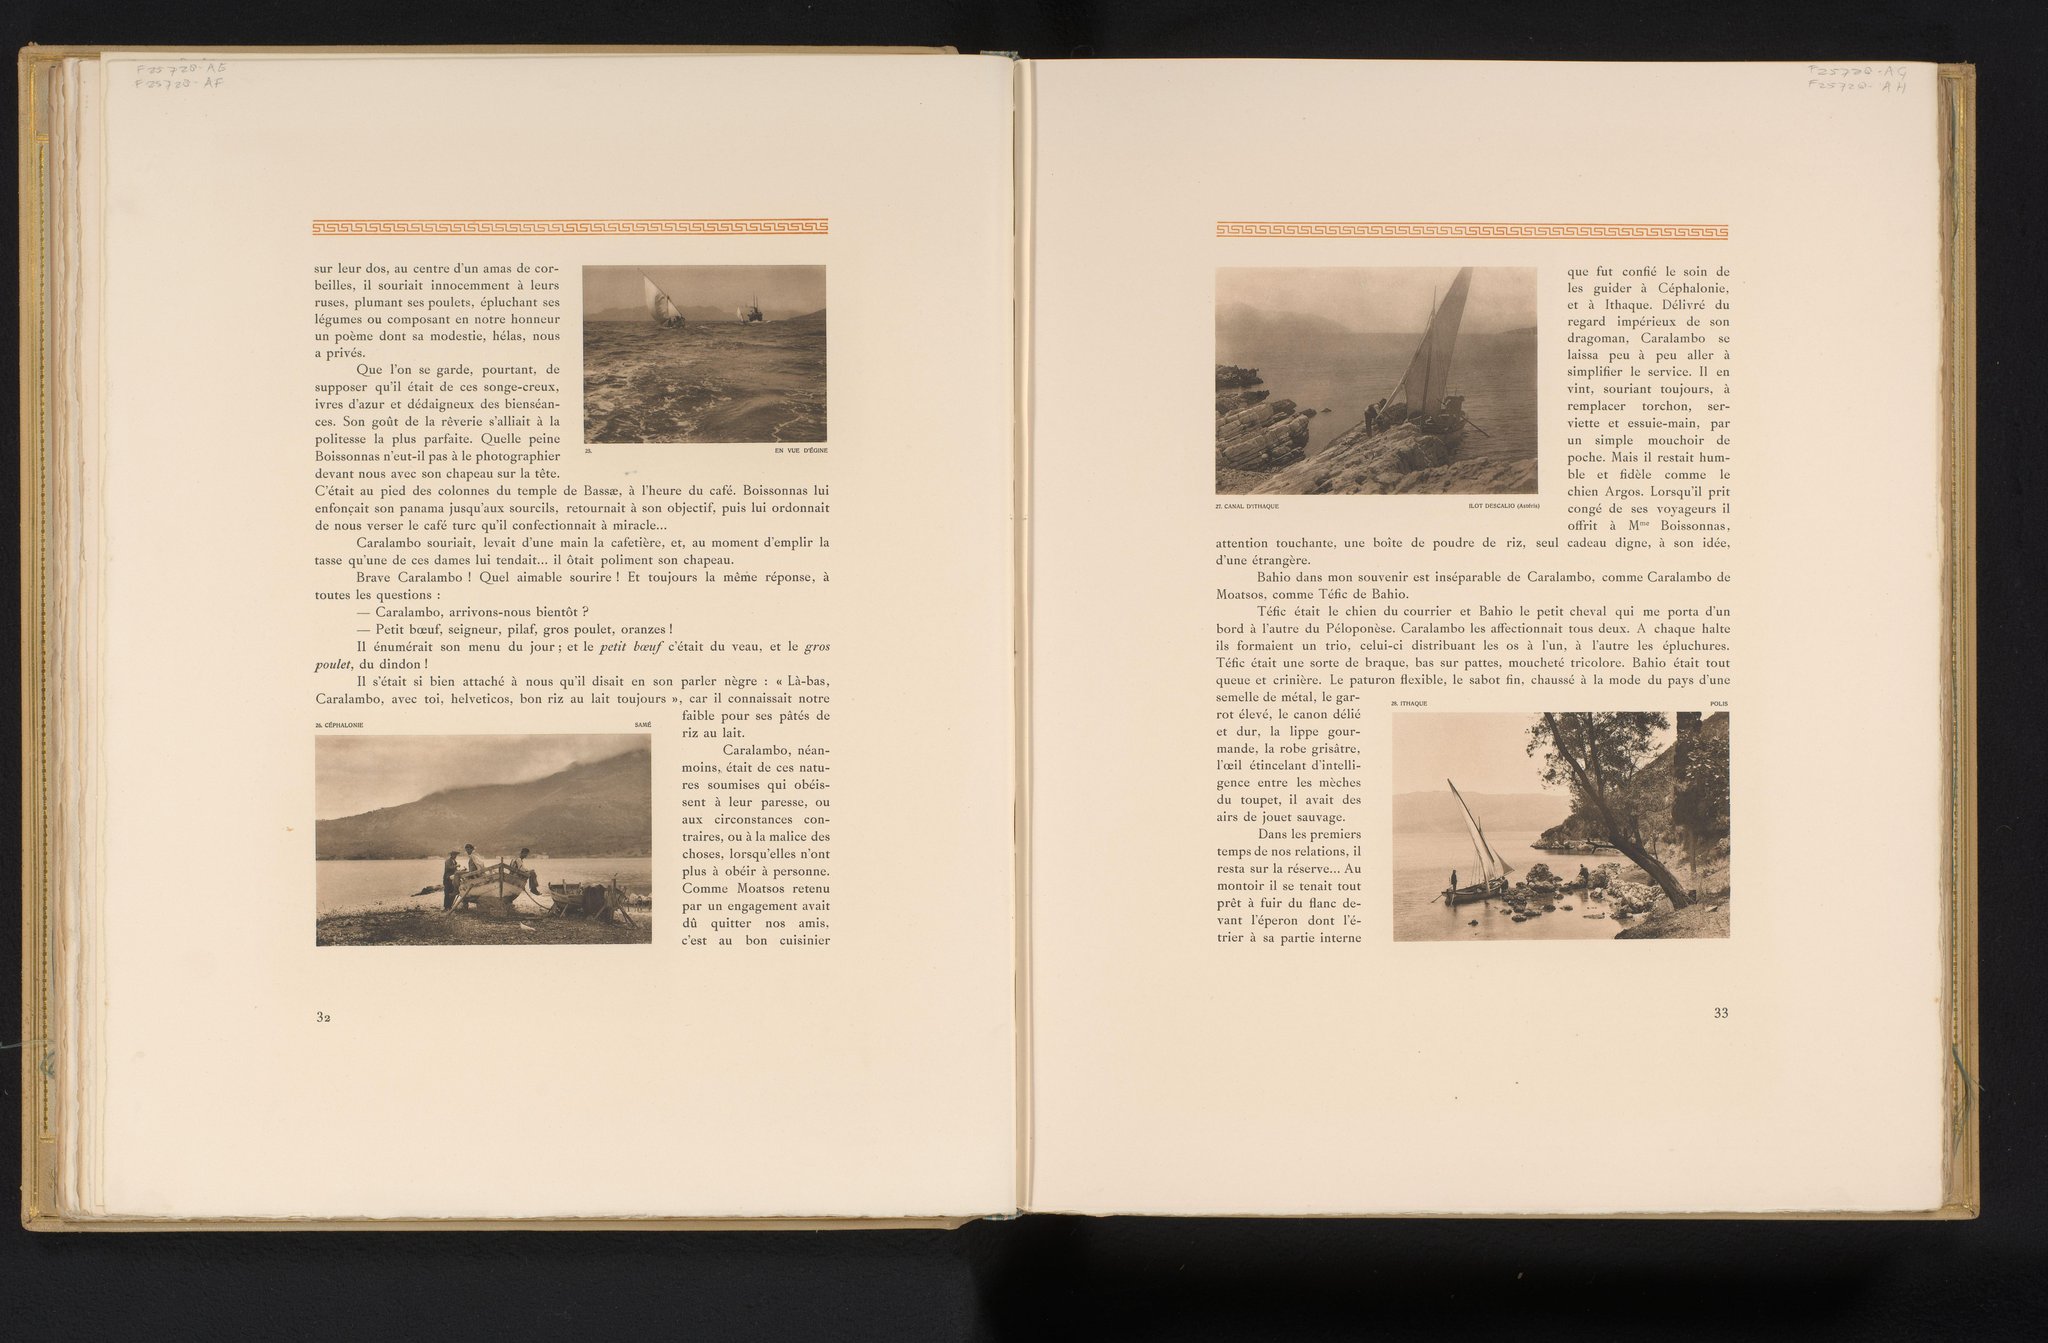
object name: photomechanical print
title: Céphalonie, Samé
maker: frédéric boissonnas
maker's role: fotograaf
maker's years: 1858-1946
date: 1905-1910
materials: paper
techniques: photograph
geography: berlin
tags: adult man, ships, boats on land, beached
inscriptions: number: ‘26.’